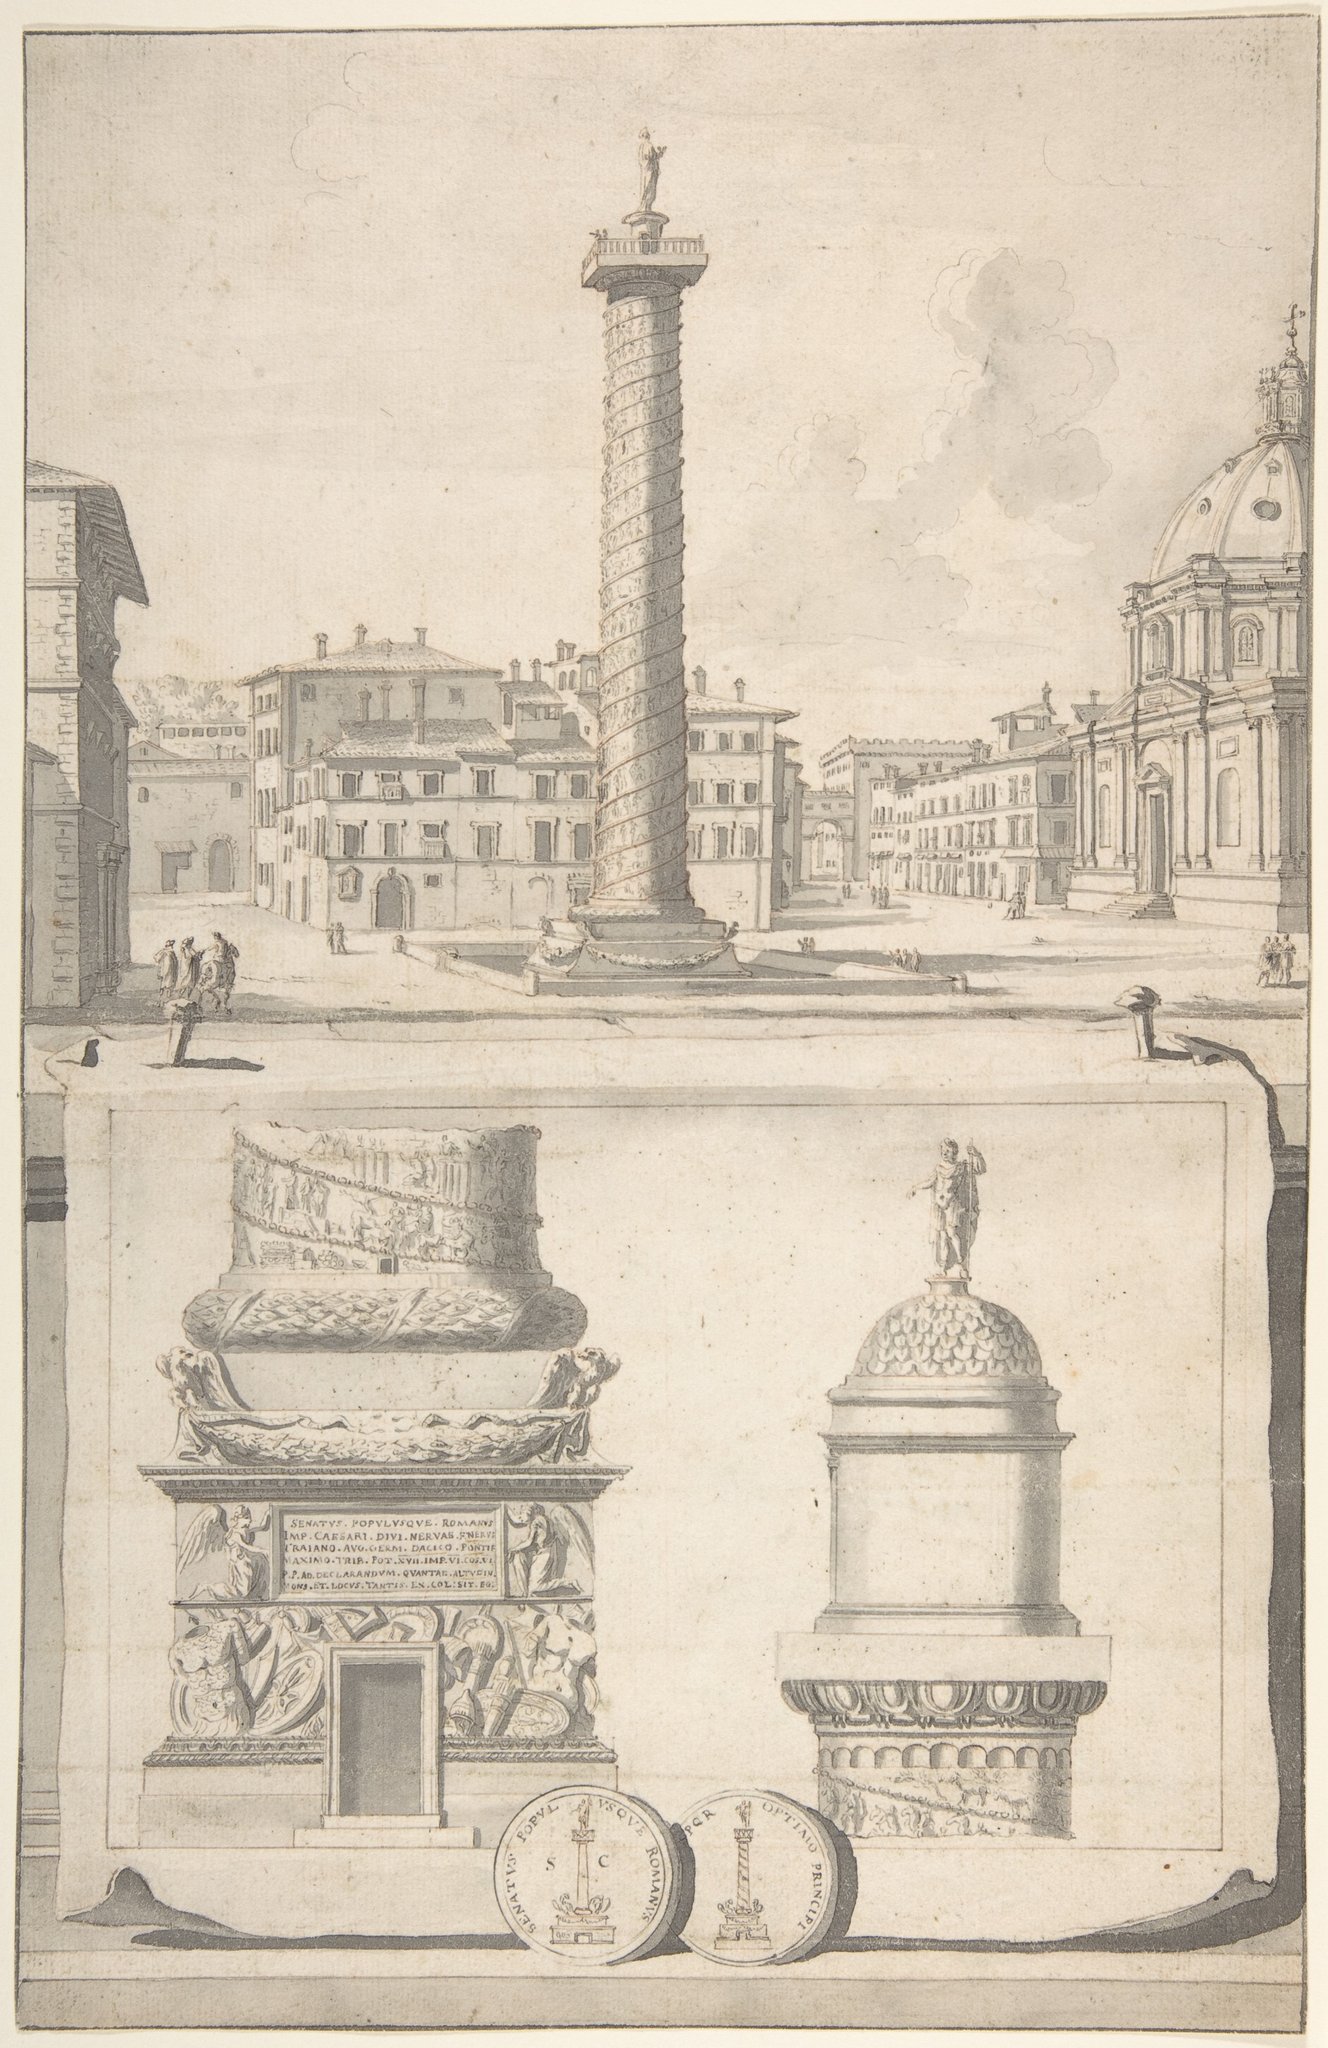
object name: drawing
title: A View of the Column of Trajan (above) with Details (below)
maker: jan goeree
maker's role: artist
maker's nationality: dutch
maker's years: 1670-1731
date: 1704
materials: chalk, ink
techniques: brush, pen, wash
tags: columns